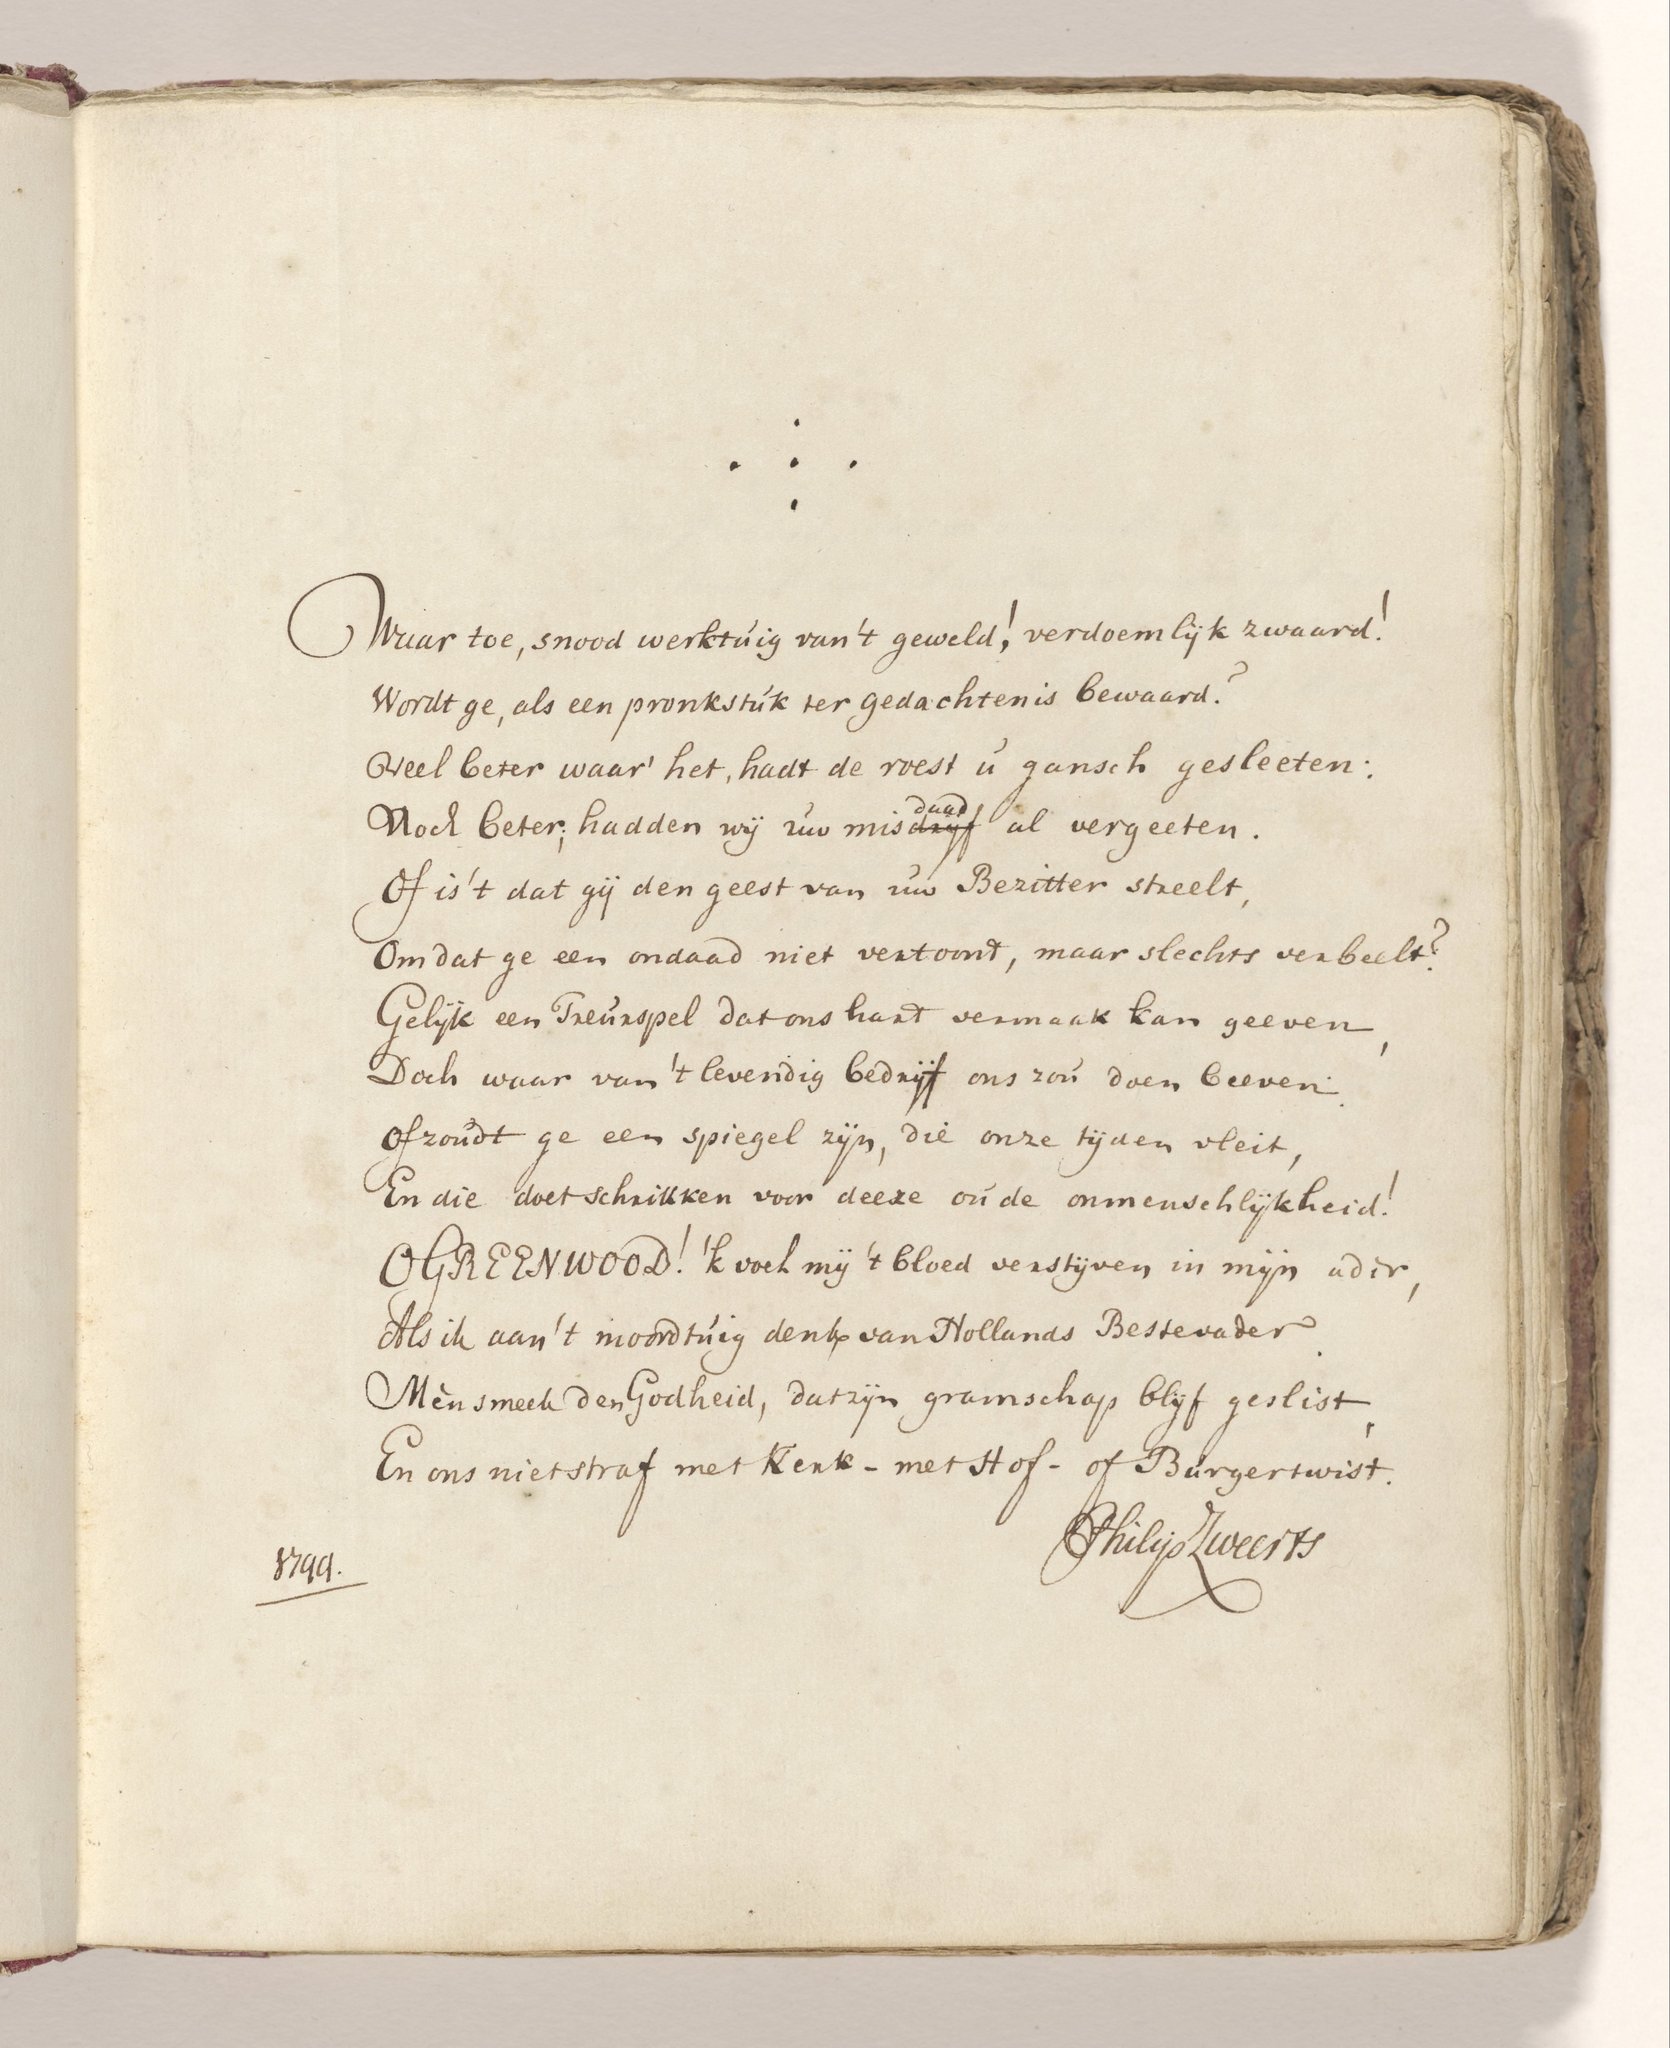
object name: manuscript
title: Gedicht op het zwaard waarmee Johan van Oldenbarnevelt in 1619 zou zijn onthoofd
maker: philip zweerts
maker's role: dichter, schrijver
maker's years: 1704-1774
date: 1744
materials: ink, paper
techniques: writing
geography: netherlands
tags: the hague, johan van oldenbarnevelt, rotterdam, dordrecht, print maker, frans greenwood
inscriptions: date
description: Vers van Philip Zweerts. Onderdeel van het boek met gedichten uit de jaren 1743-1745 op het zwaard waarmee Johan van Oldenbarnevelt in 1619 zou zijn onthoofd. Het zwaard was eigendom van Frans Greenwood.